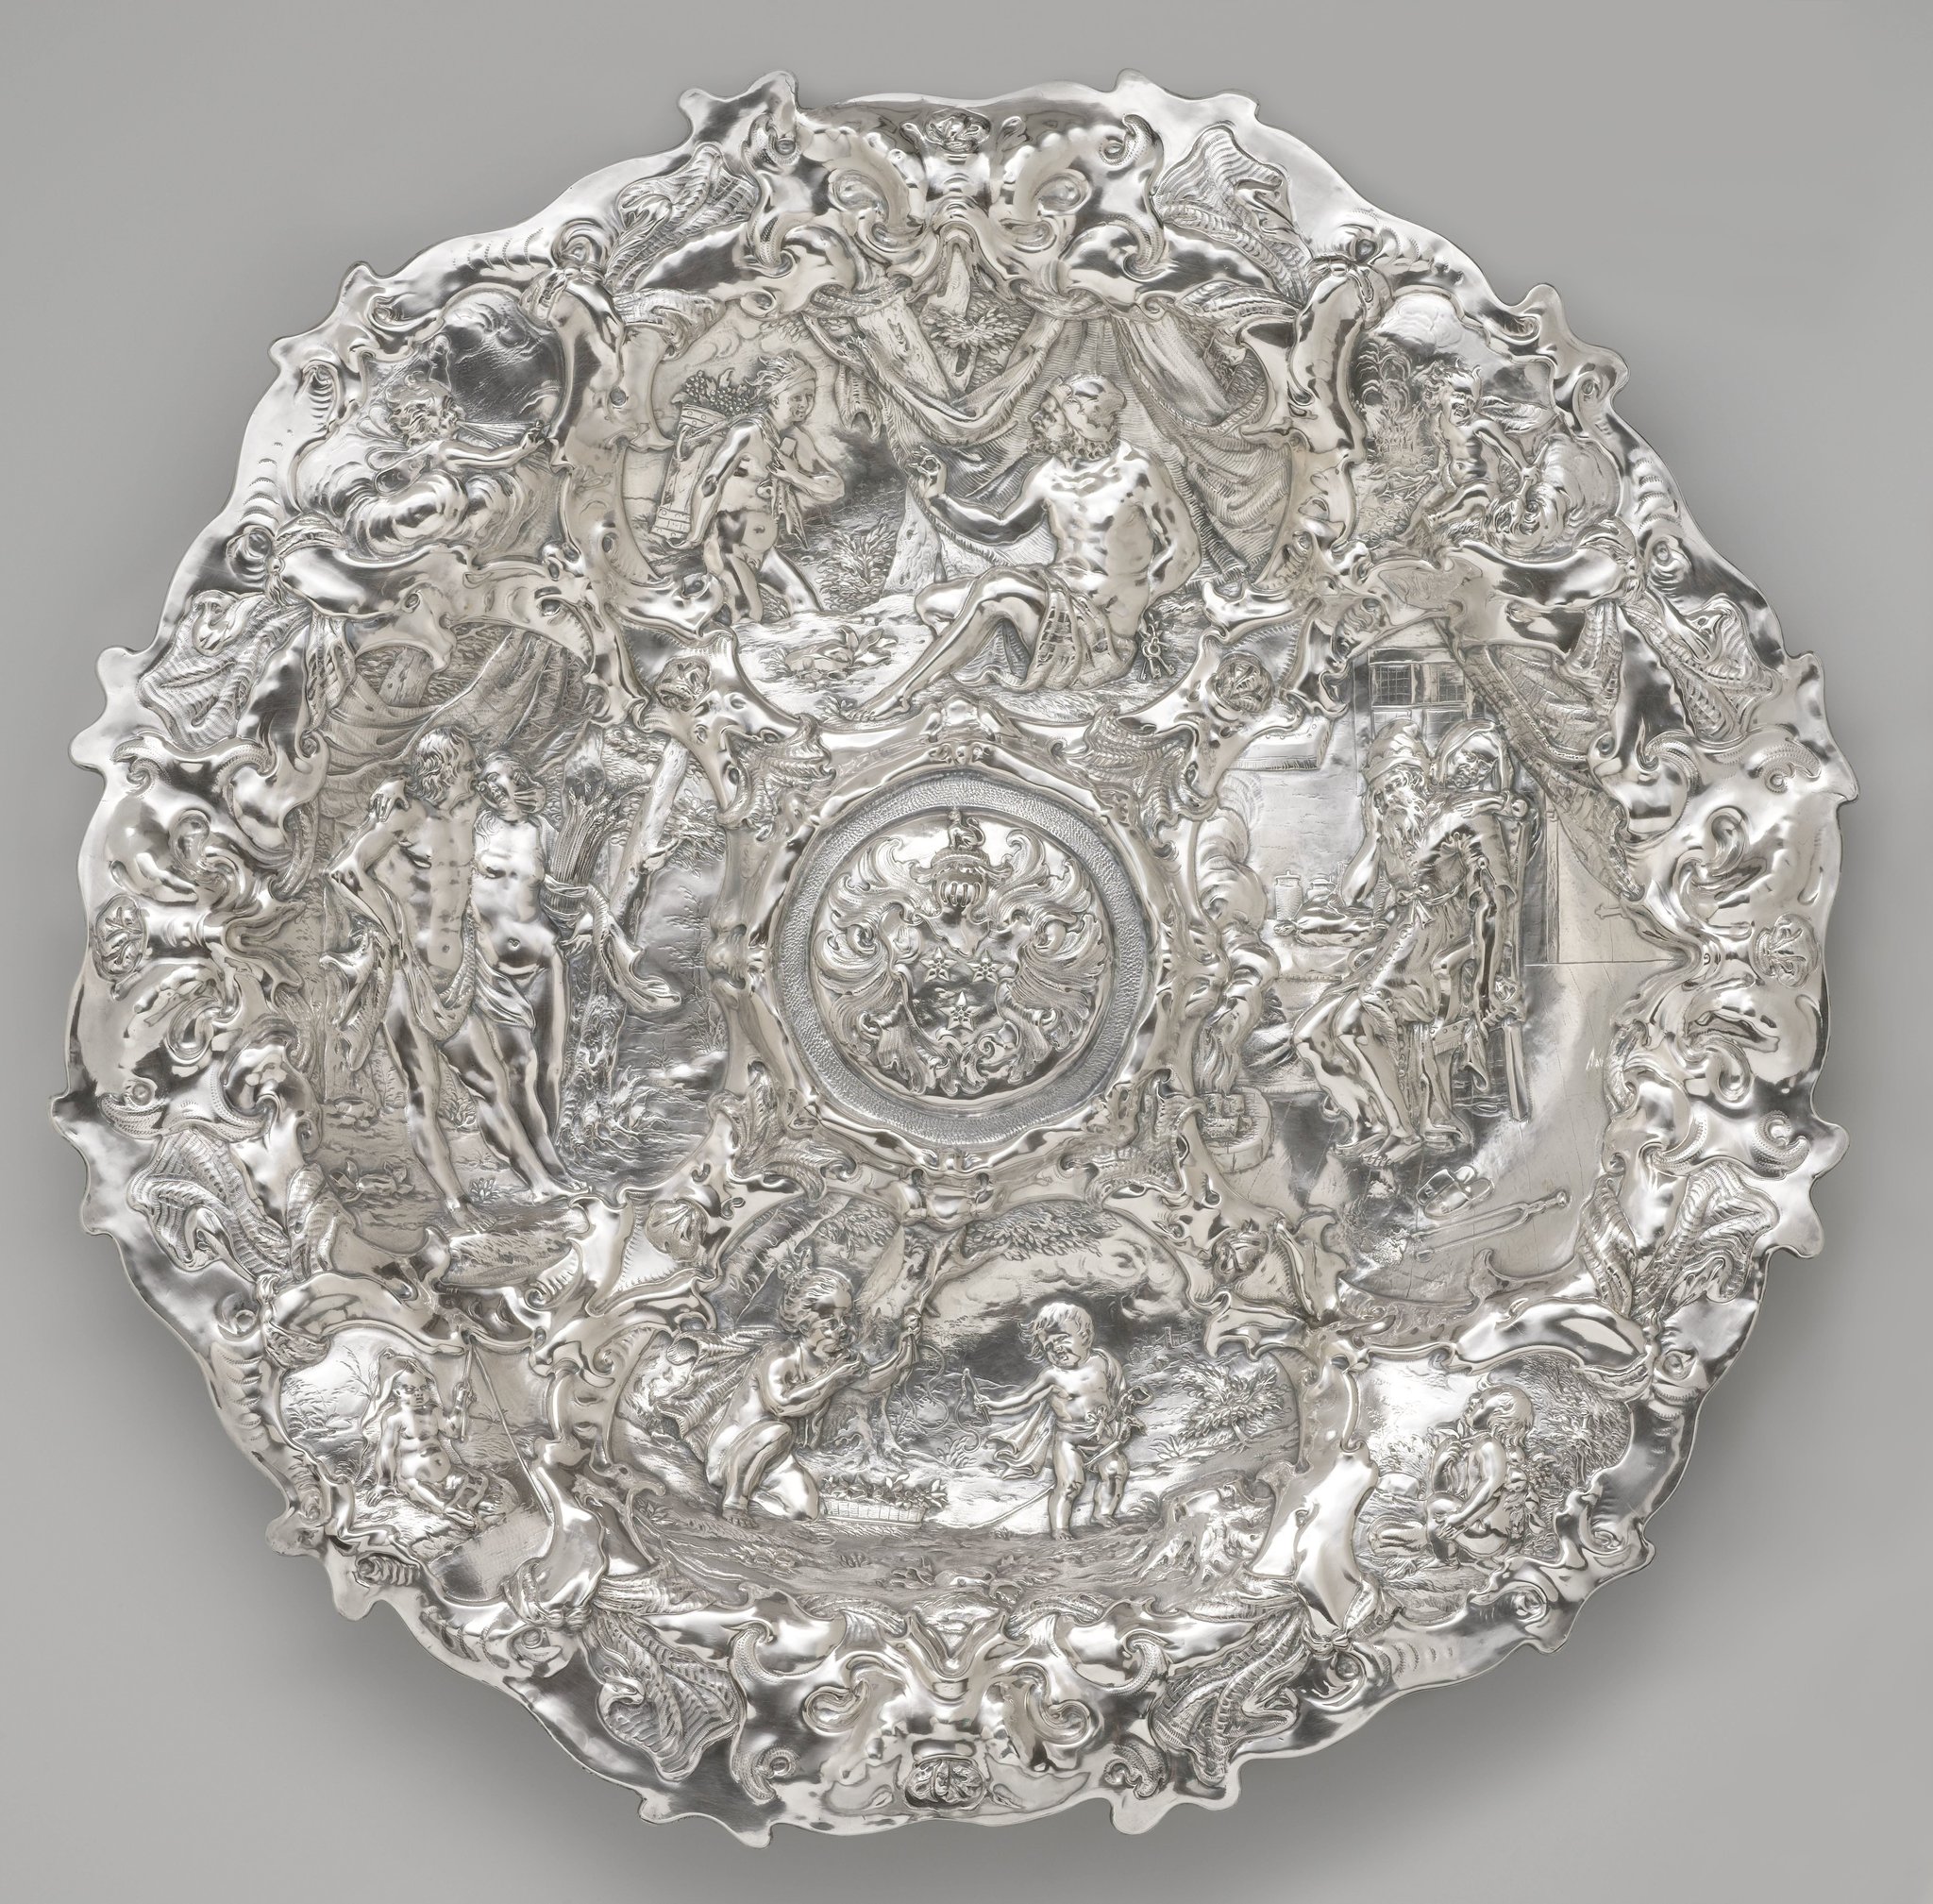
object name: dish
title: Ewer and basin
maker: johannes grill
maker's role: silversmith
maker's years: 1614-1670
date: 1649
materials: silver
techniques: repoussé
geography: amsterdam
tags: auricular ornament, lobe style ~ ornament, the four elements, and ether, the fifth element, seasons of the year (esp. personifications); 'stagione', 'le quattro stagione dell'anno' (ripa)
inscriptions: mark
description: Scenes chased on silver were an Amsterdam speciality. This ewer and basin demonstrate Johannes Grill’s mastery in combining fanciful motifs with Classical figures. His work was also admired outside of the Netherlands: this ensemble, for instance, was made for Edward Sebright, an English nobleman. These showpieces were used to wash one’s hands before and after a meal.